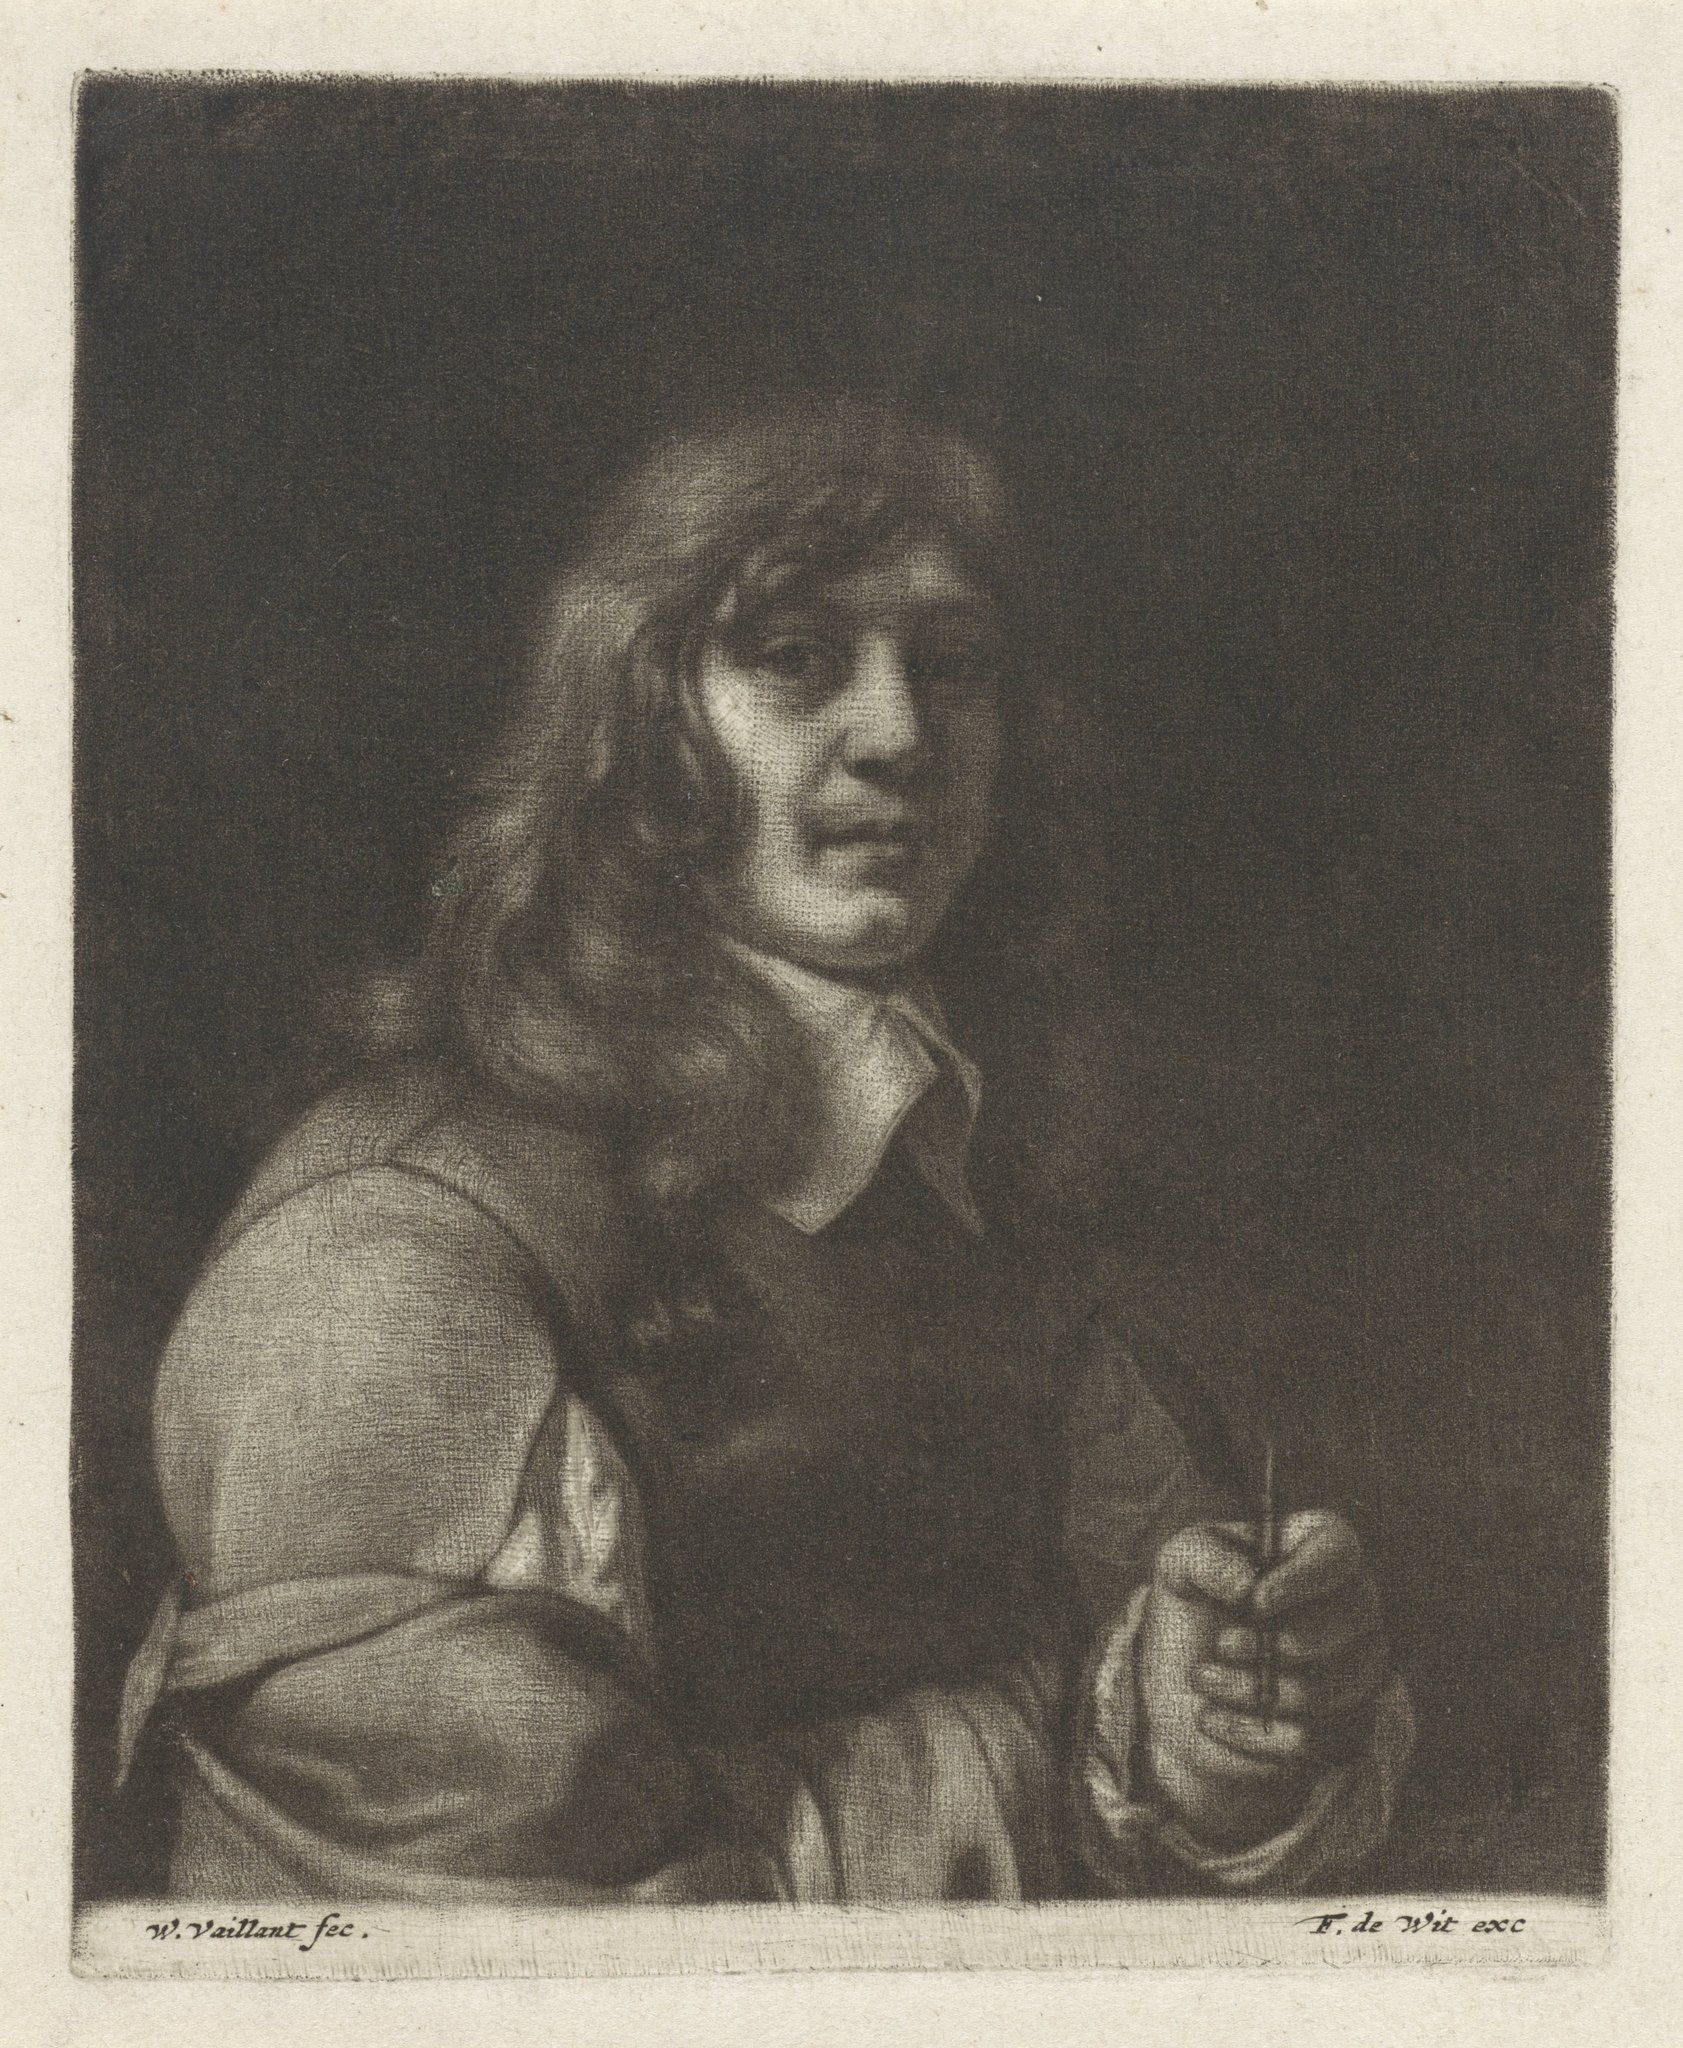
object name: print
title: Portret van Jacob van der Does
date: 1658-1706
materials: paper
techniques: mezzotint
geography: amsterdam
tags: amsterdam, painter, draughtsman, jacob van der does (i), portrait, self-portrait of painter, tools, implements of draughtsman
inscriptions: collector's mark: Lugt 2228, collector's mark: Lugt 514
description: De schilder, tekenaar en prentmaker Jacob van der Does met een tekenpen in de hand.